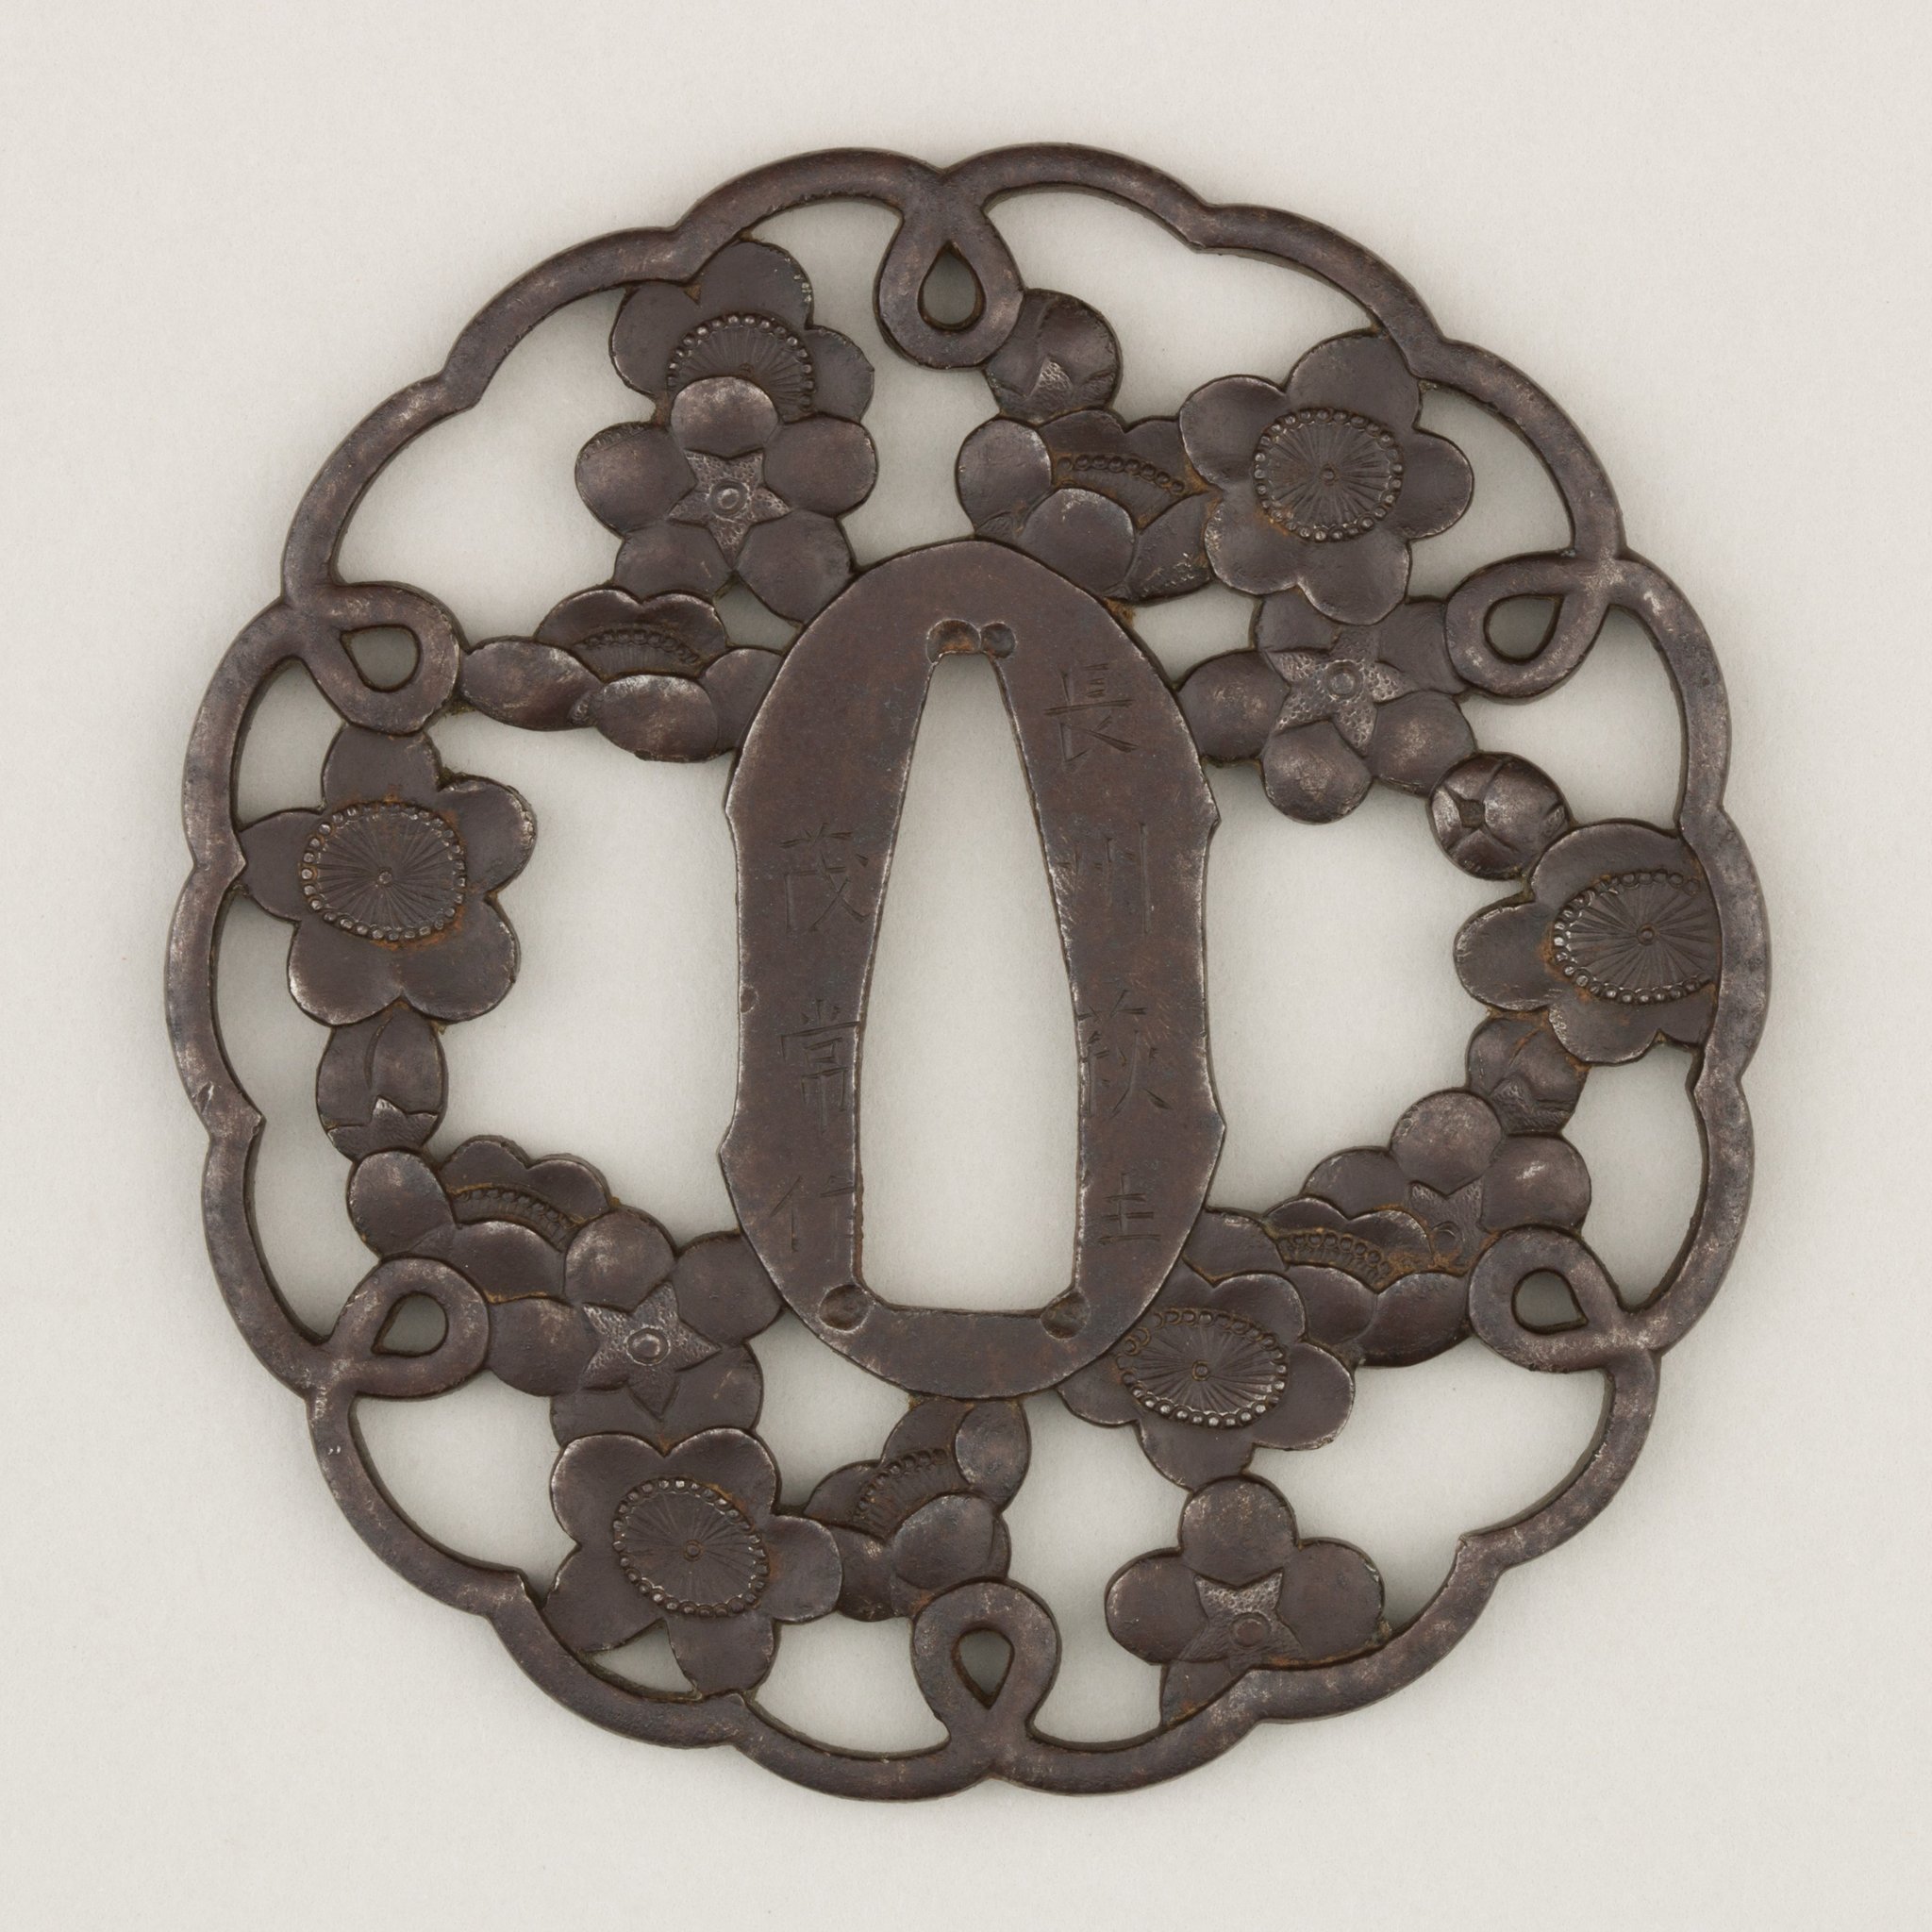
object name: sword guard tsuba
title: Sword Guard (Tsuba)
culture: japanese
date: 1801-1900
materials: copper, iron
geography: japan